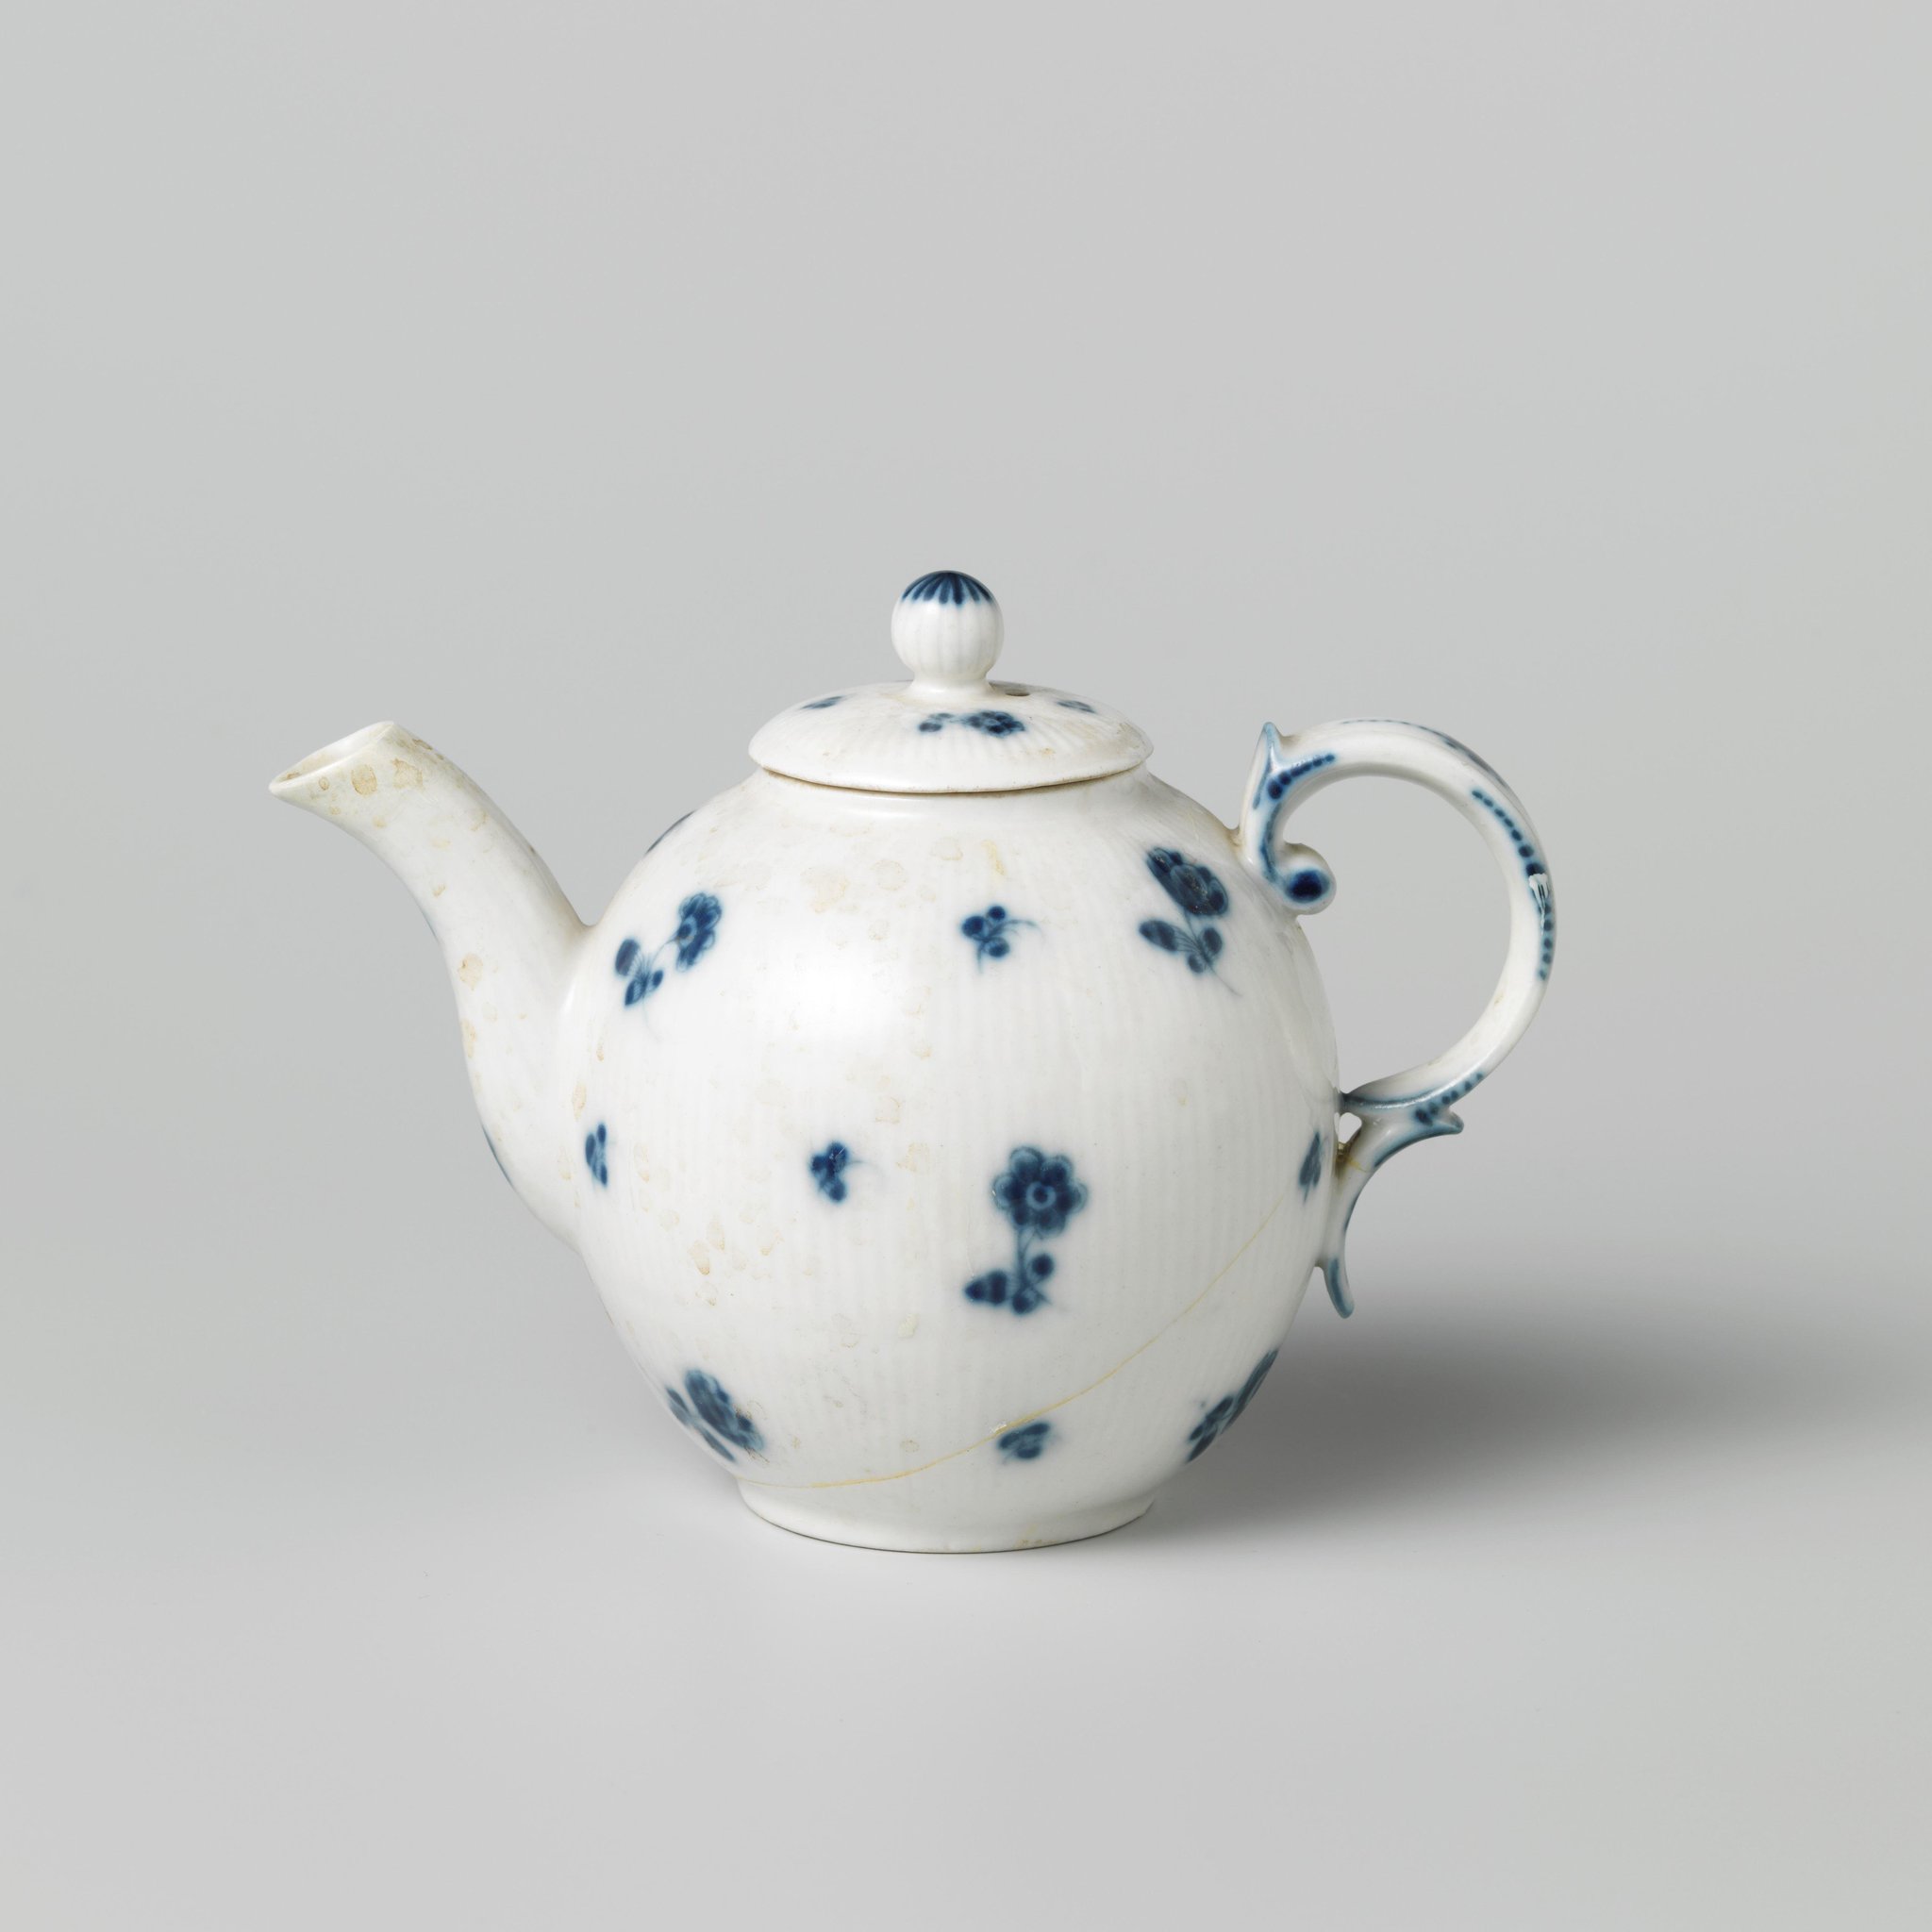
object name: teapot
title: Theepot, beschilderd met strooibloemen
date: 1784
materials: porcelain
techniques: painted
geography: loosdrecht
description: Delen van een koffie- en theeservies bestaande uit een koffiekan, een theepot, een melkkan en een suikerpot geribd met een blauw strooipatroon van bloemen onder het glazuur. Gemerkt: koffiekan Amstel in blauw, theepot M:O L in blauw en ingegrift, melkkan MOL en Amstel in blauw en suikerpot * M:OL in blauw en ingegrift M:OL L80.